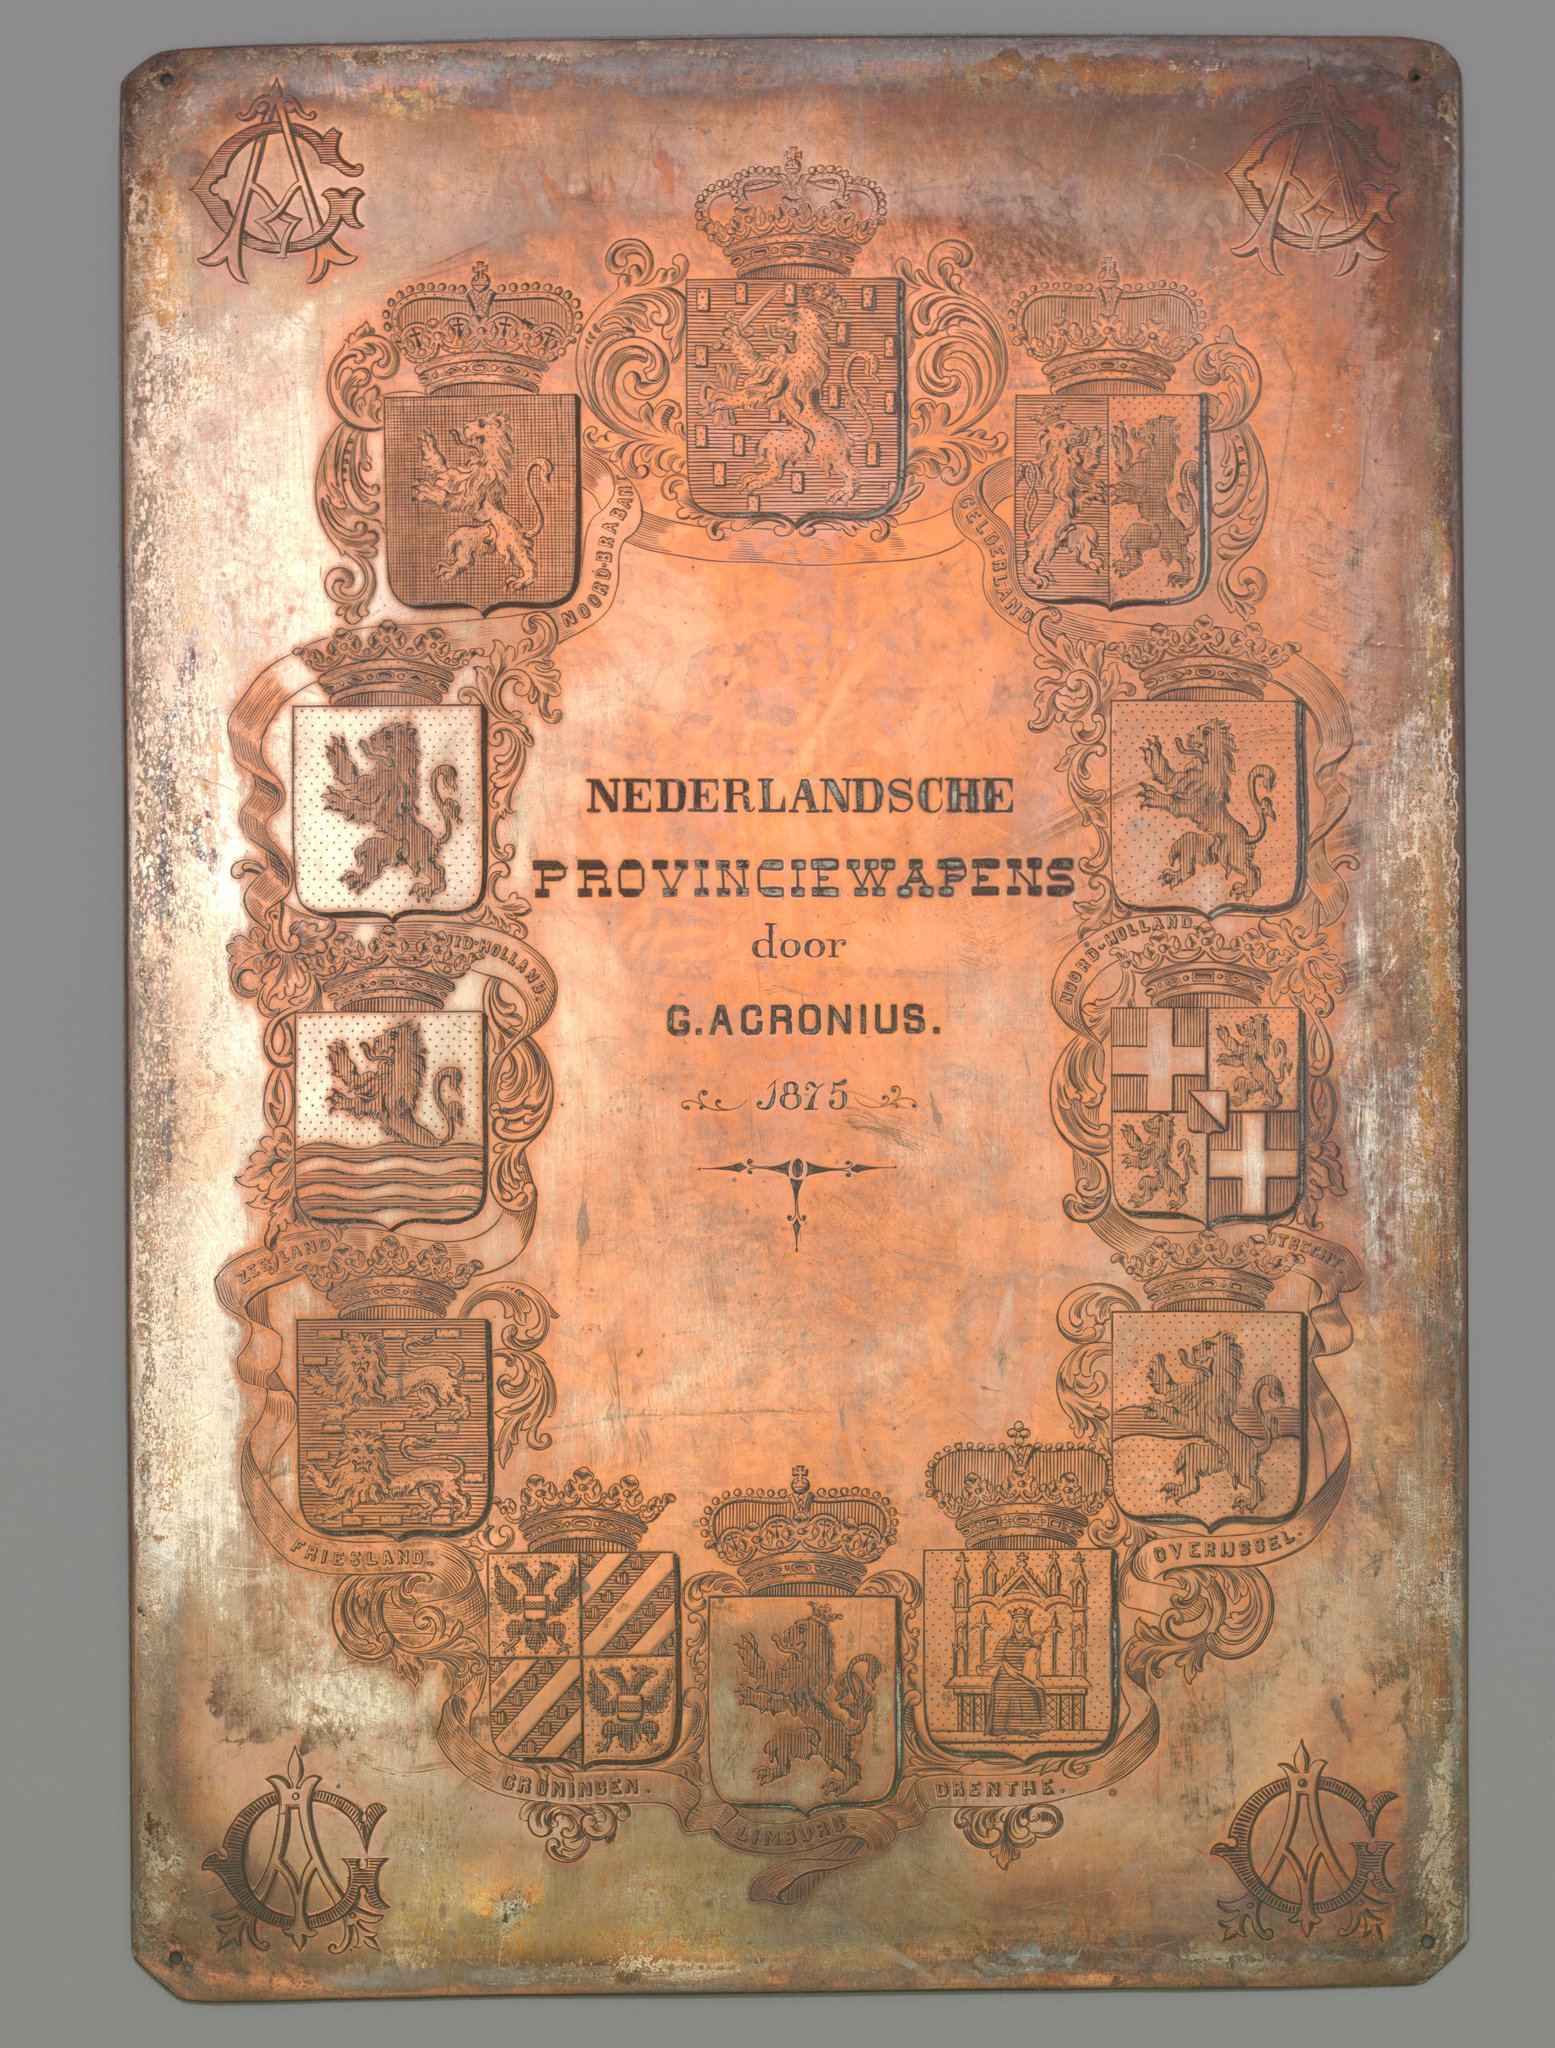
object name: copper plate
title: Titelpagina voor de Nederlandse Provinciewapens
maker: g. acronius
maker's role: print maker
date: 1875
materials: copper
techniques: engraving